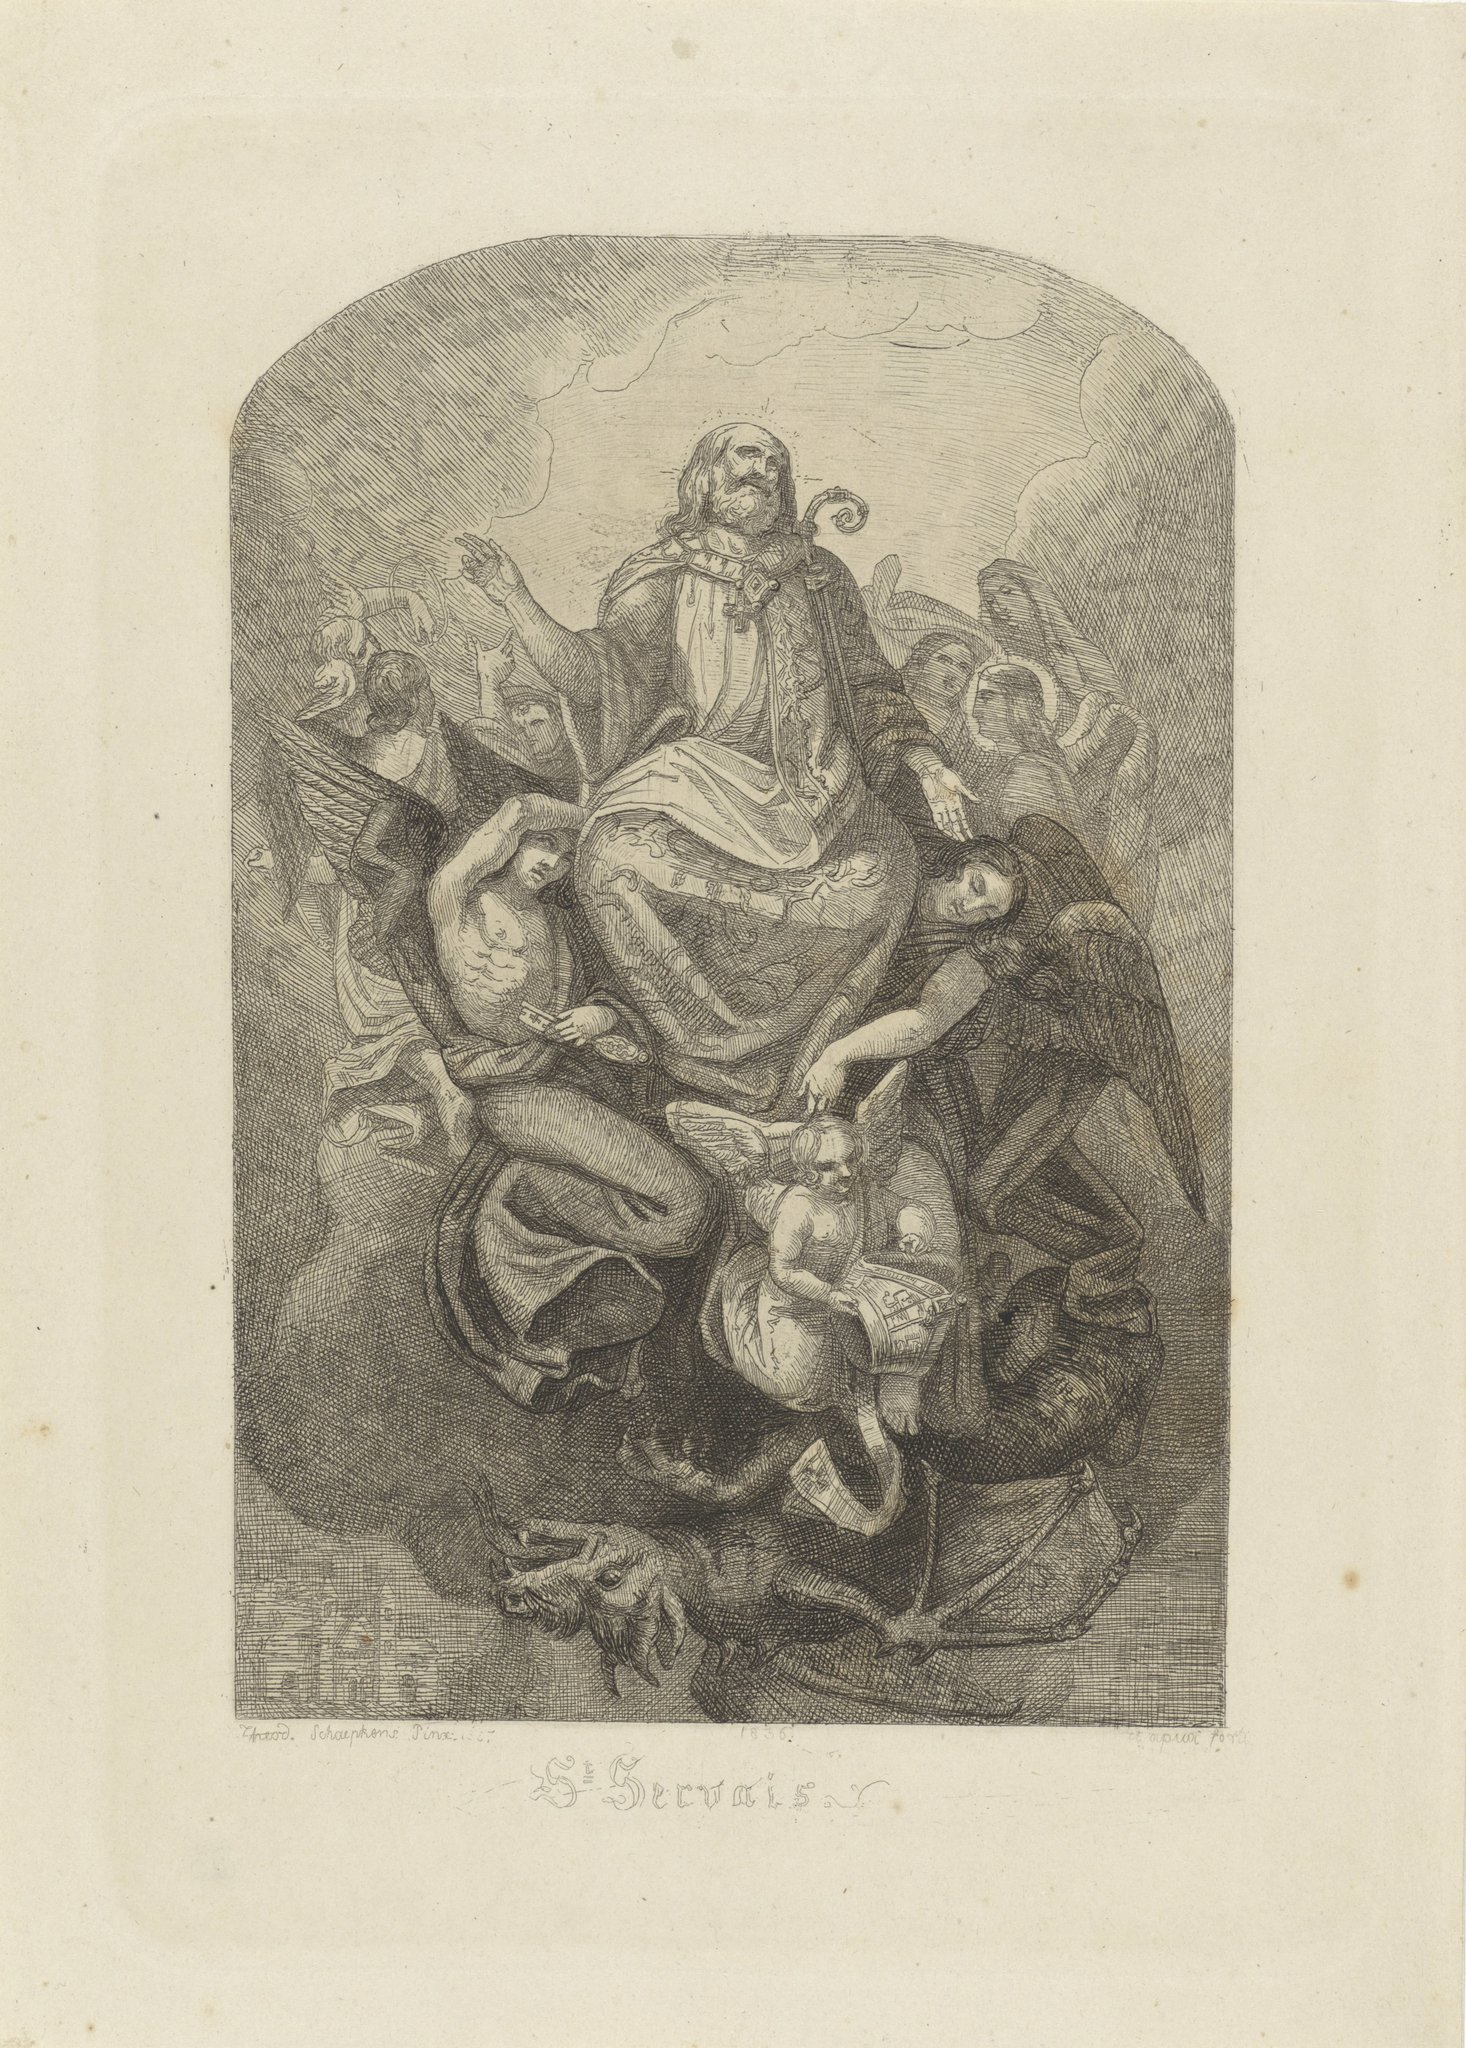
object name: print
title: St. Servais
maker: theodoor schaepkens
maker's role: draughtsman, print maker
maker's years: 1810-1883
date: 1837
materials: paper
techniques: etching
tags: servatius, bishop of tongeren and maastricht; possible attributes: clog (wooden shoe), dragon, eagle, key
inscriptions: collector's mark: Lugt 2228, collector's mark: Lugt 1485